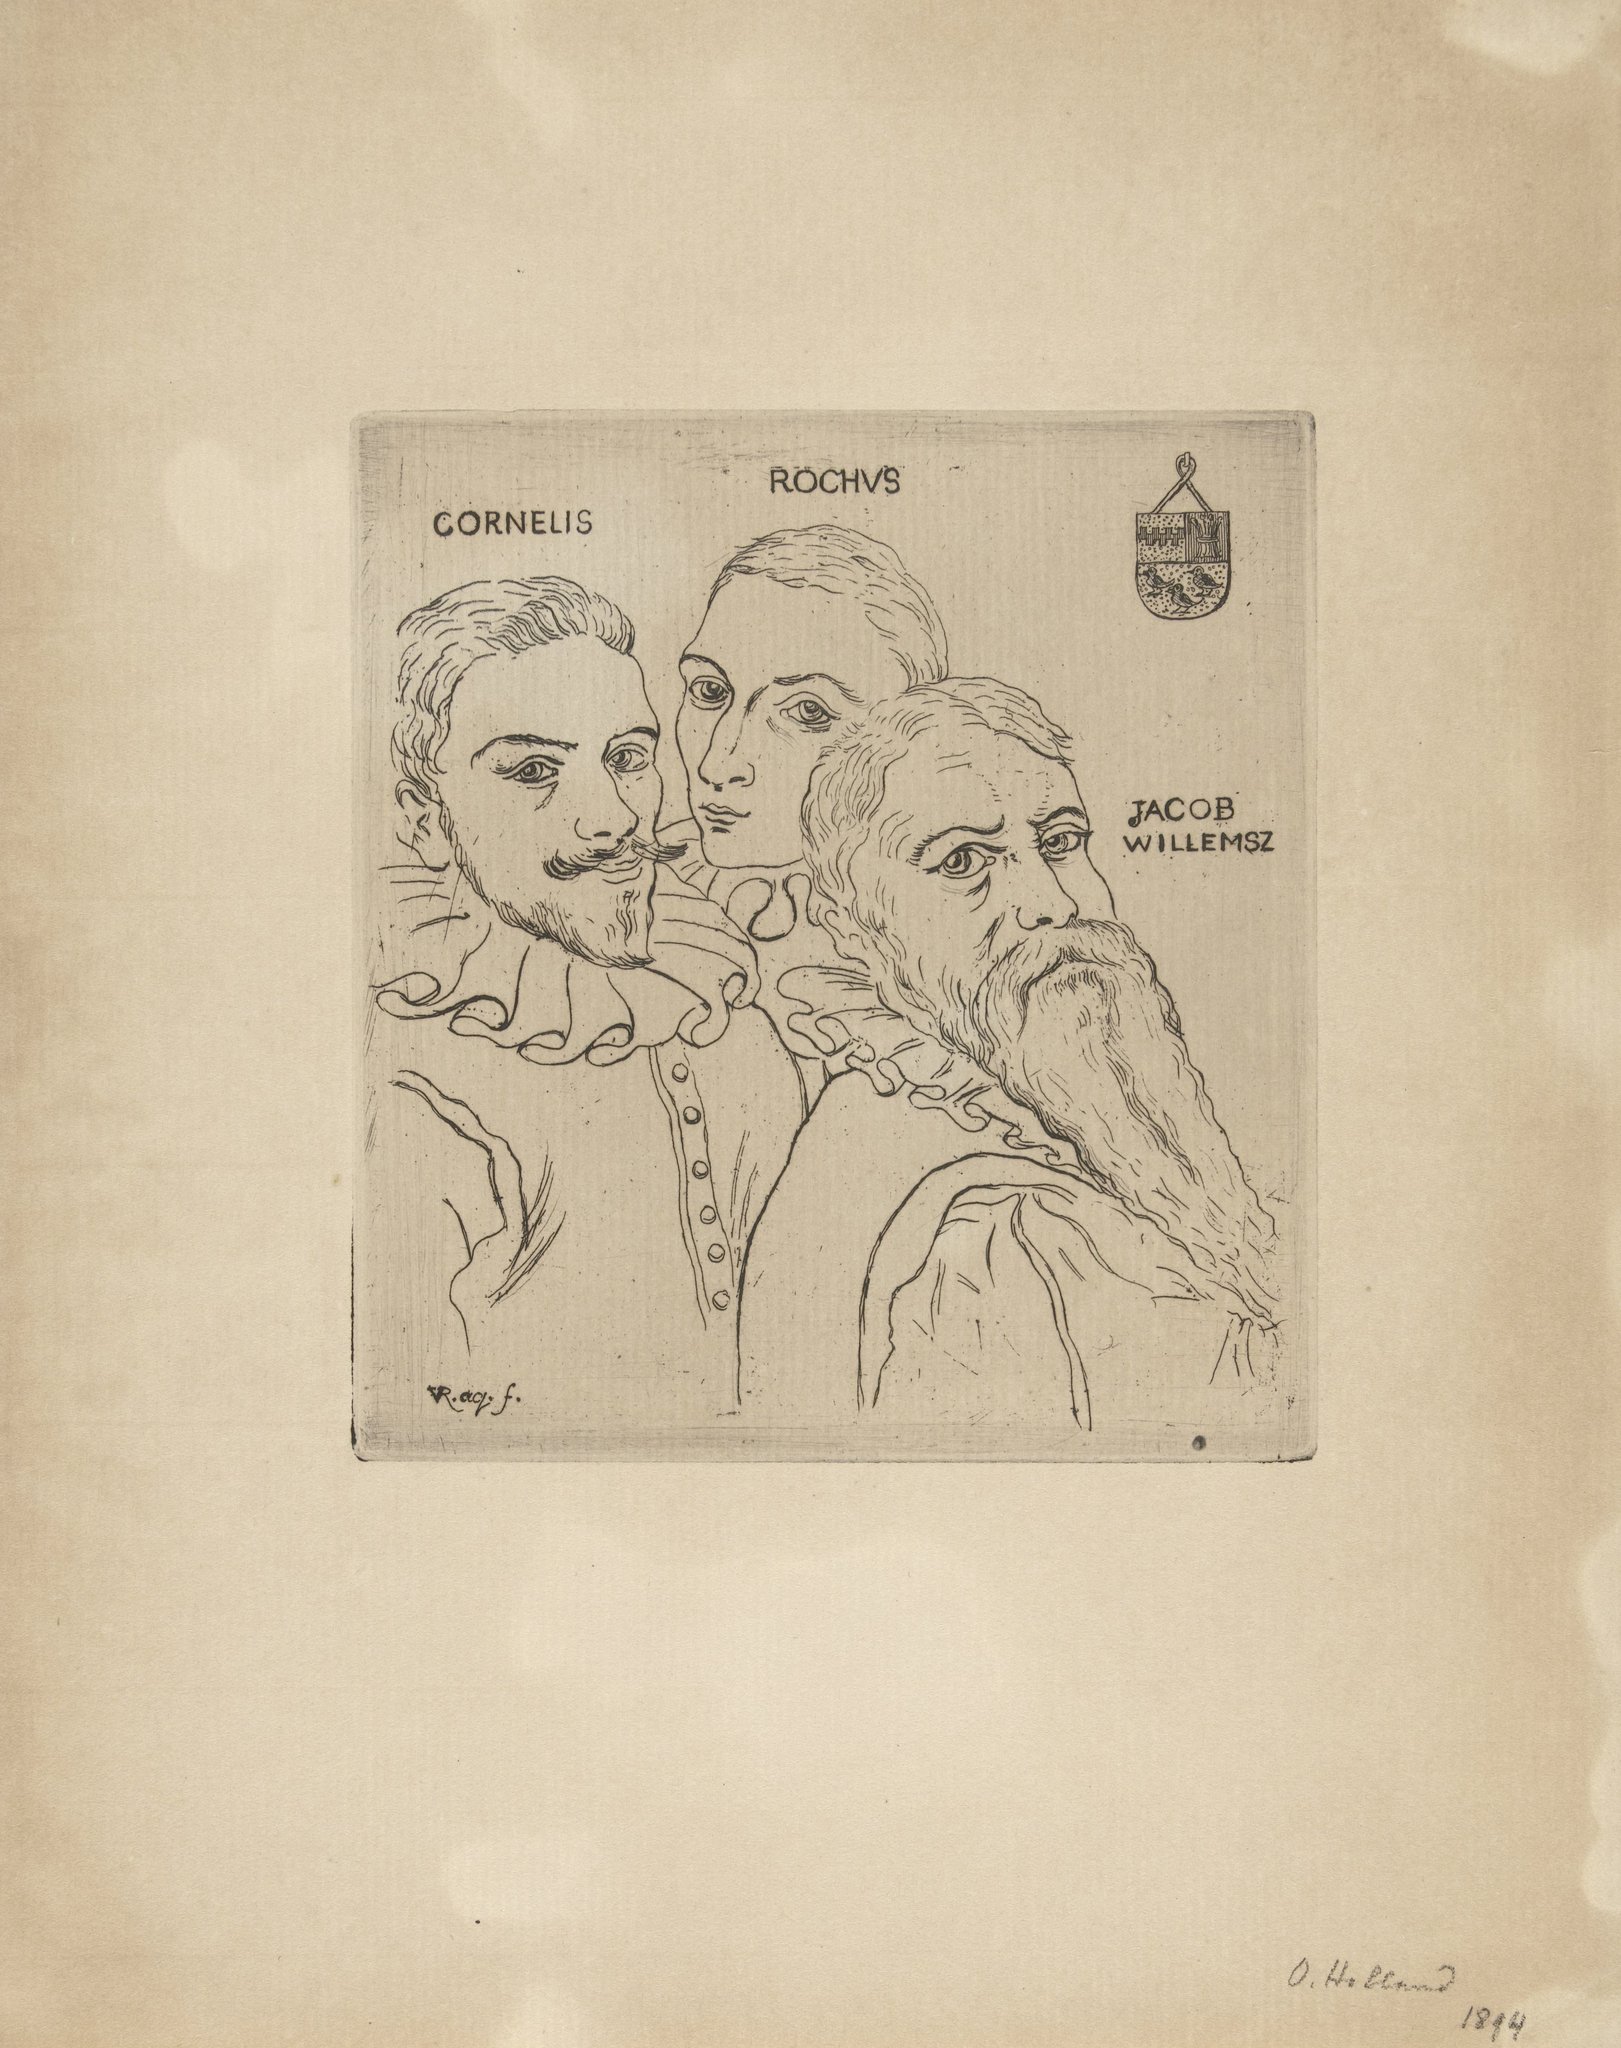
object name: print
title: Portret van Cornelis Rochus en Jacob Willemz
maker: jonkheer barthold willem floris van riemsdijk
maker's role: engineer, print maker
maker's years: 1850-1942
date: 1894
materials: paper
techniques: etching, intaglio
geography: netherlands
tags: adult man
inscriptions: collector's mark: Lugt 2228